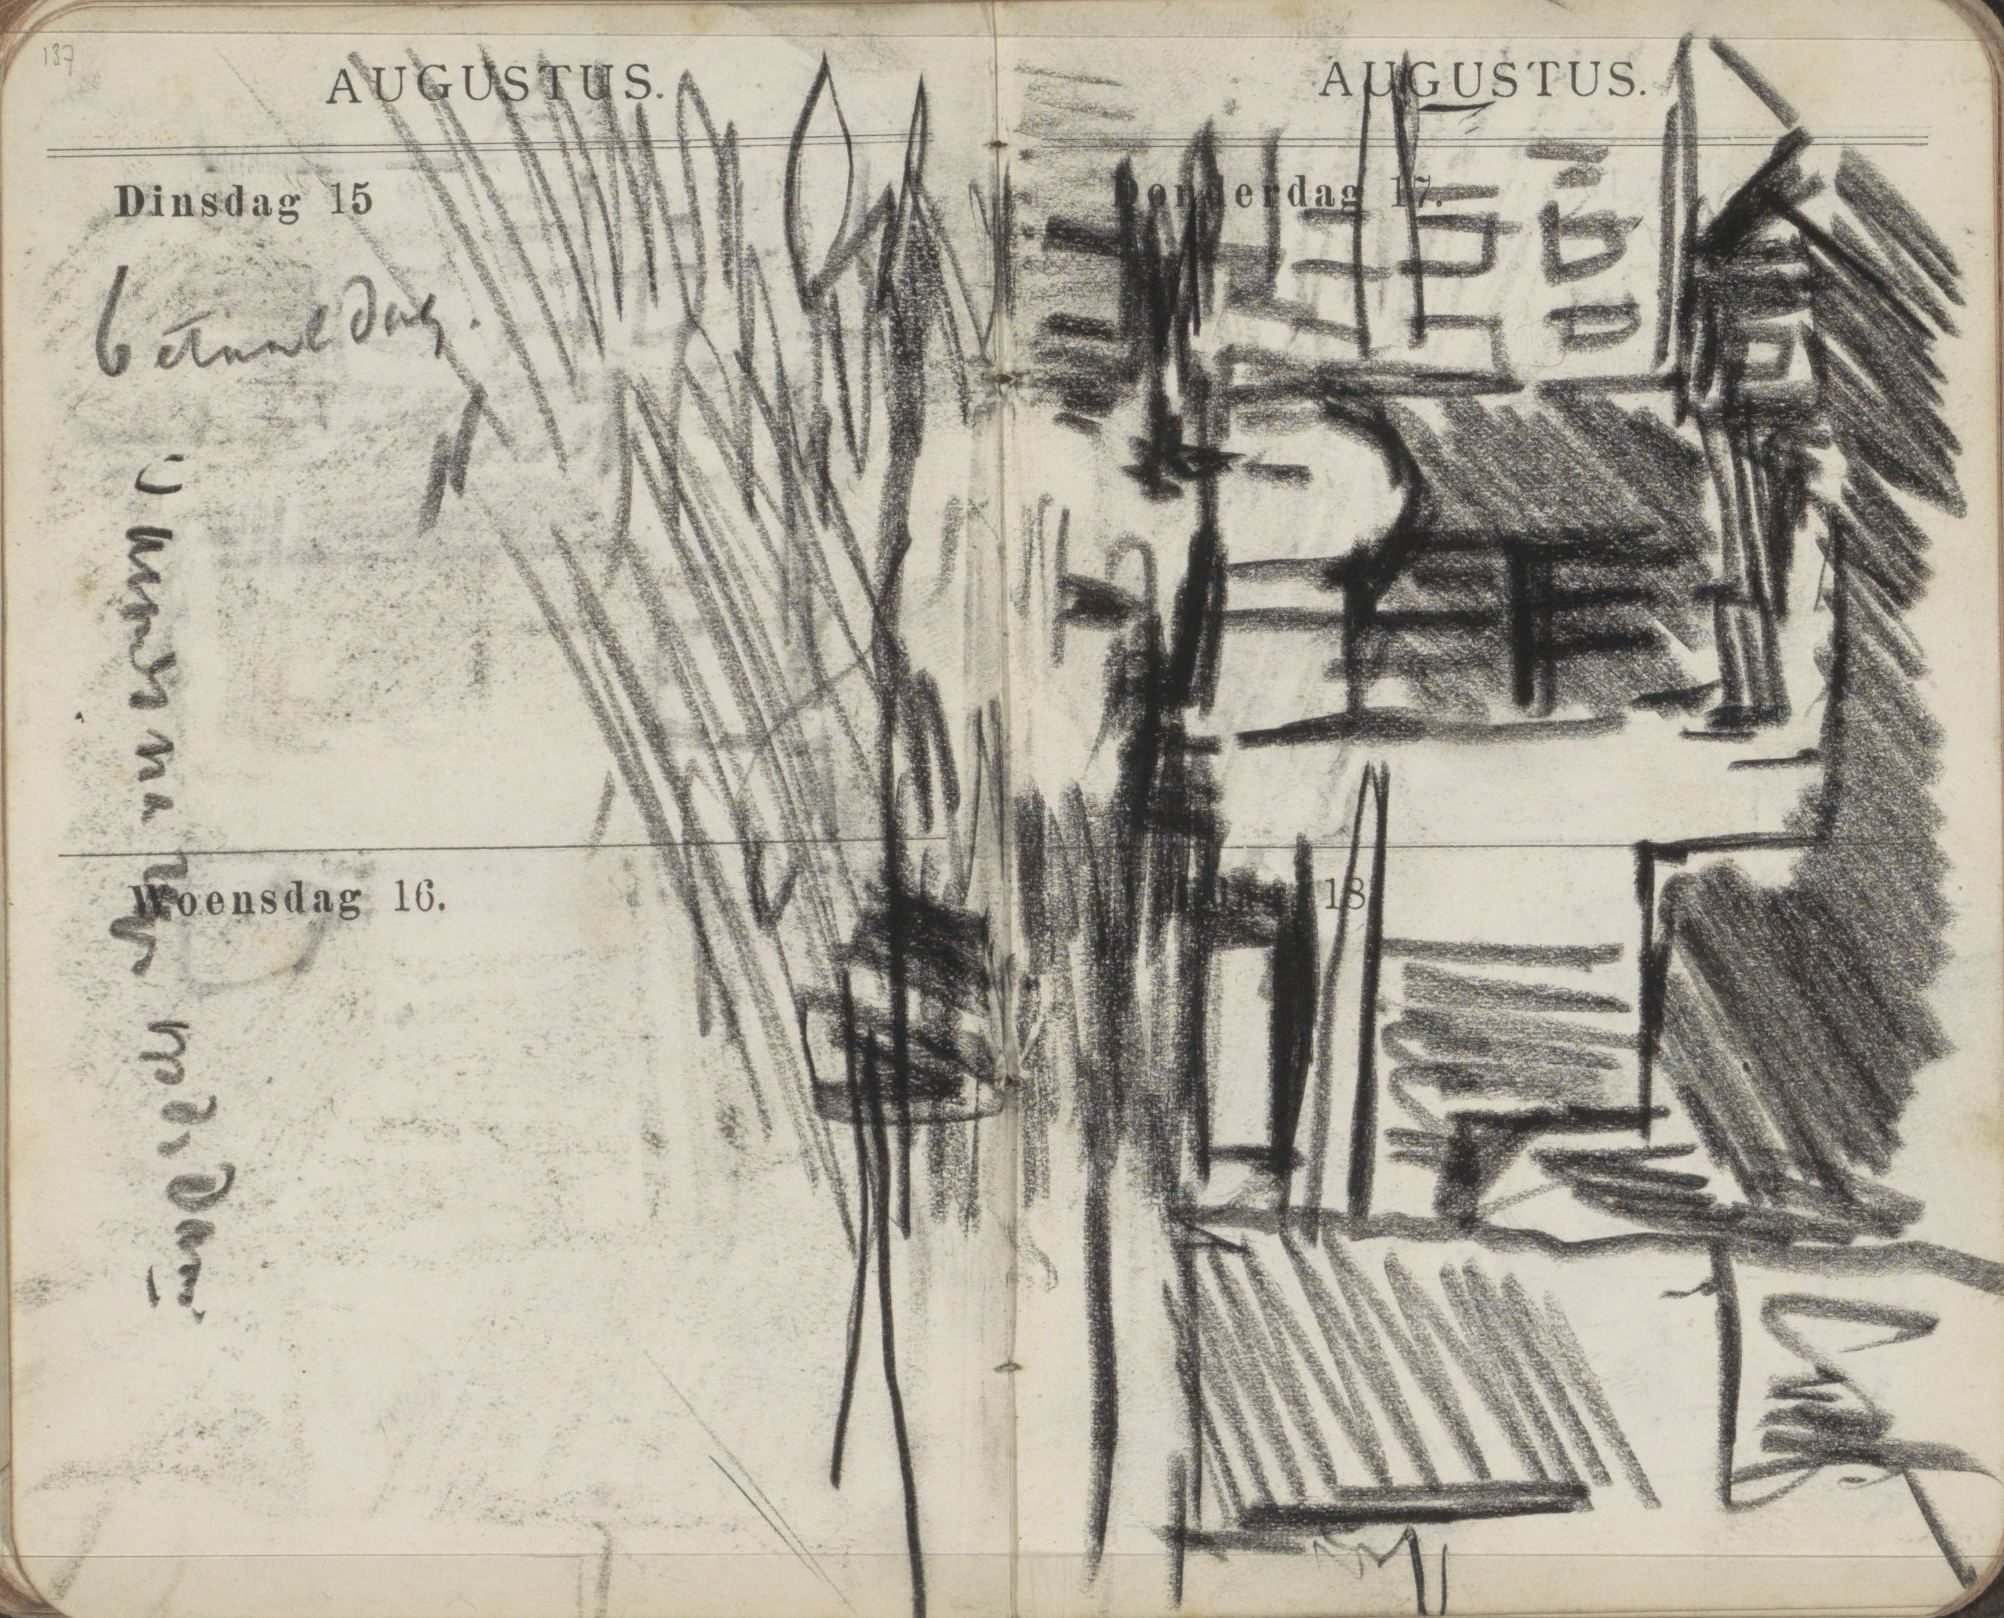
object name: sketchbook leaf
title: Gezicht op de Dam te Amsterdam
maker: george hendrik breitner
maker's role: draughtsman, painter, print maker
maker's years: 1857-1923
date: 1893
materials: chalk, paper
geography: amsterdam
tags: square, place, circus, etc., civic architecture; edifices; dwellings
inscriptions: annotation: ‘betuwedag[?]/ 's avonds na regen op de Dam’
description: Rechts mogelijk Naatje. Pagina 137 en pagina 138 uit een als schetsboek gebruikte agenda met 108 bladen.